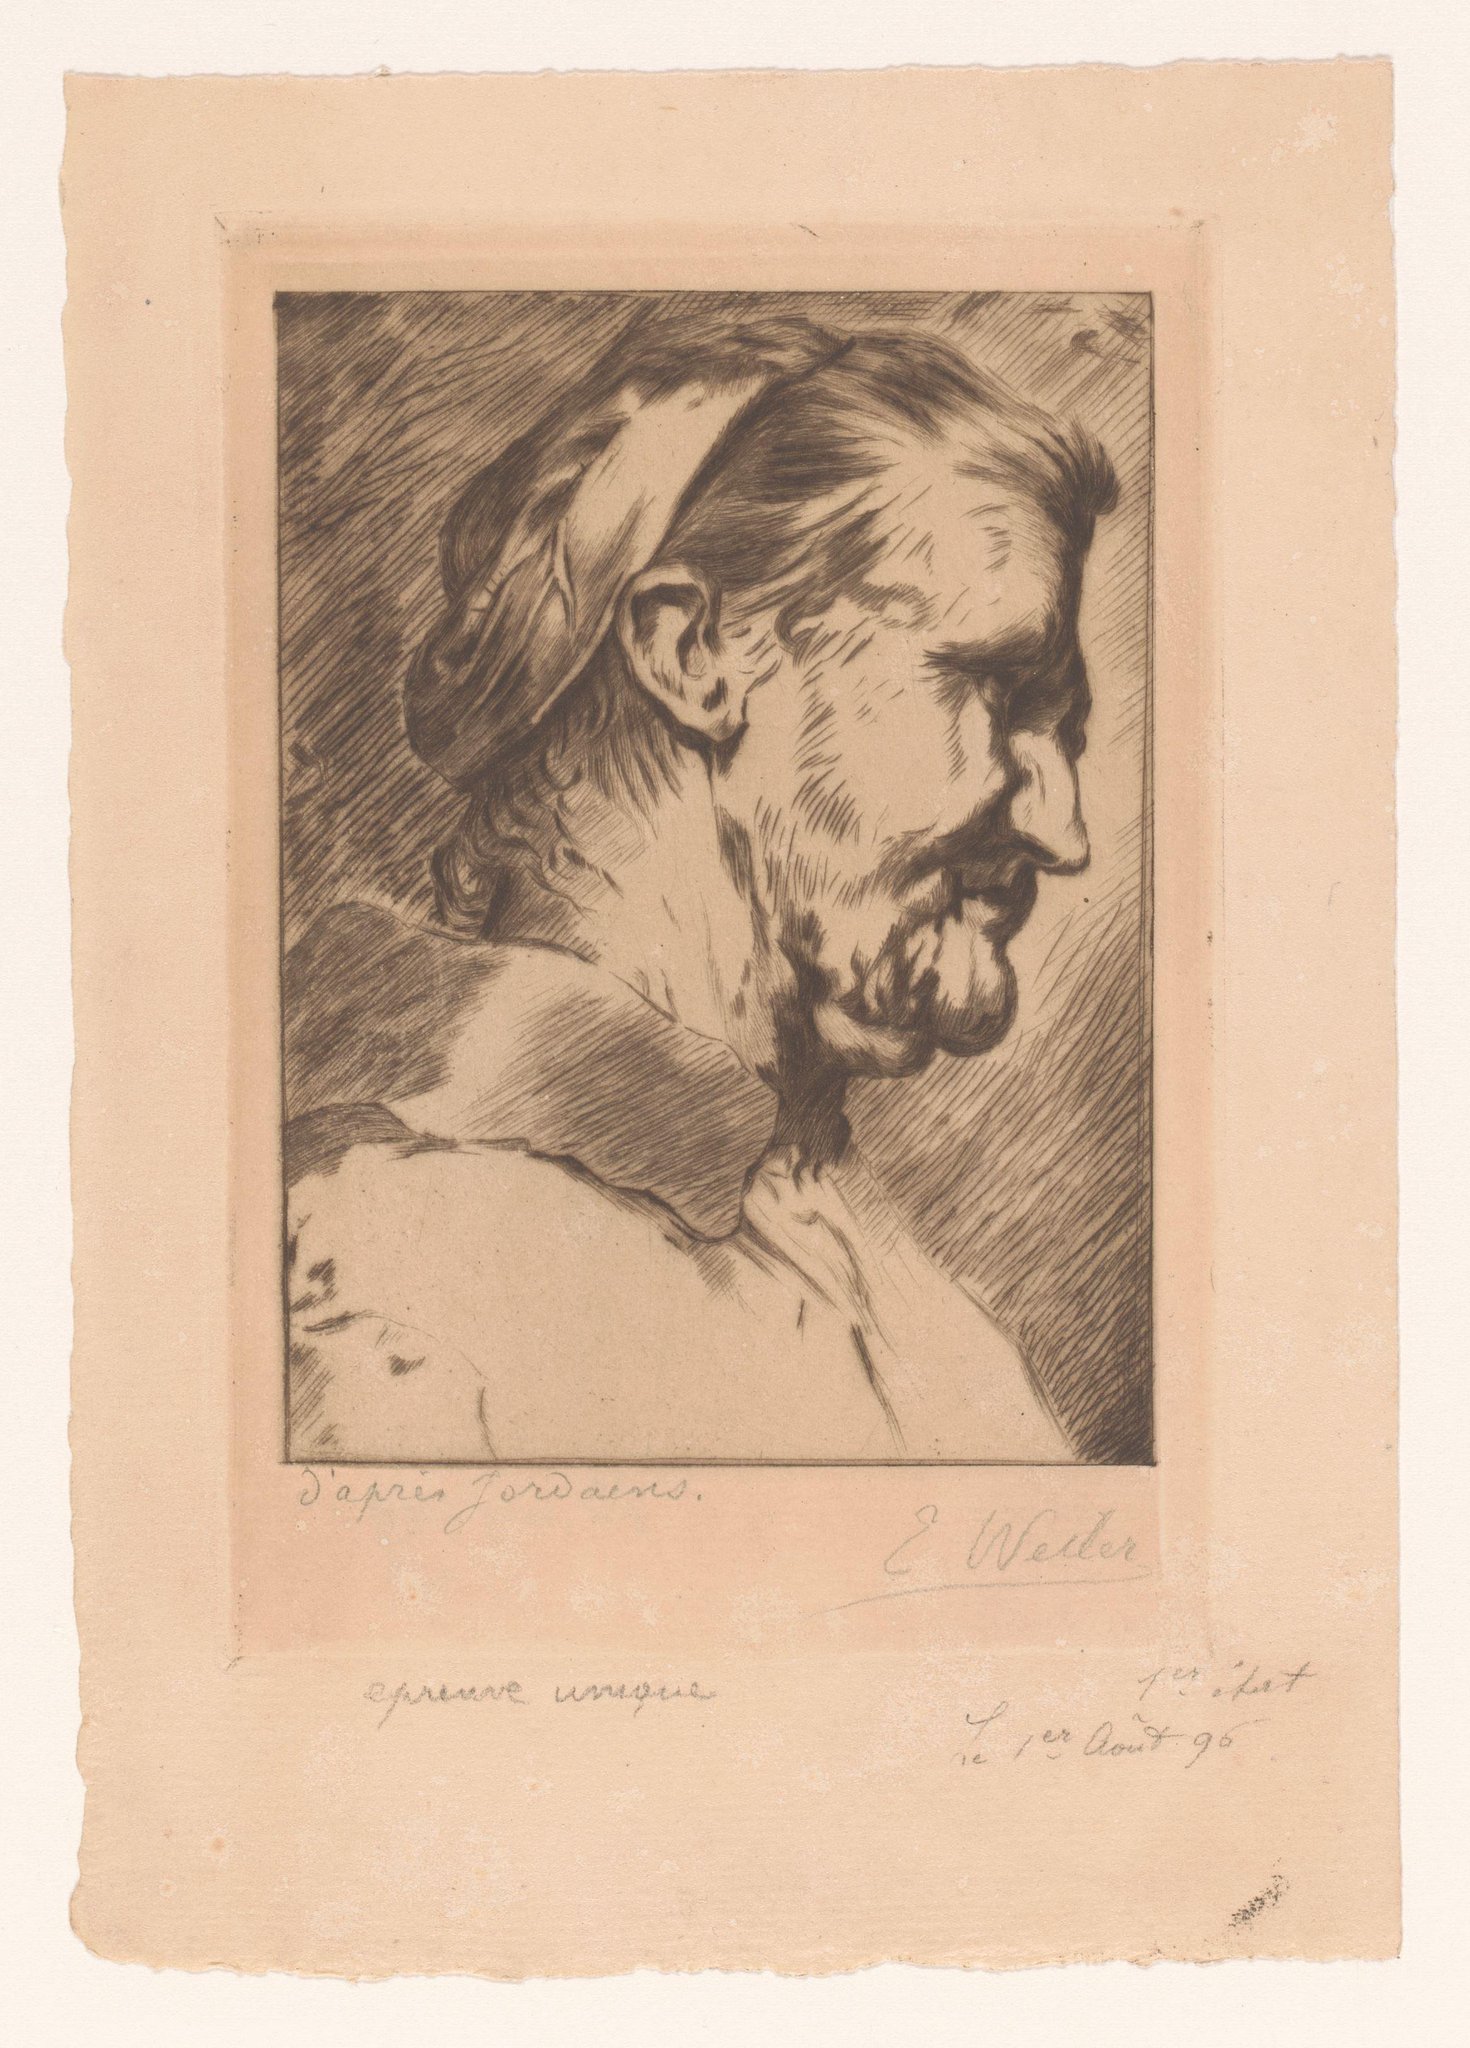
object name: print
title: Hoofd van een oude vrouw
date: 1896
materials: paper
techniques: drypoint, etching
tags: old woman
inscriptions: collector's mark: Lugt 2228, inscription: ‘d'apres Jordaens; epreuve unique; 1er état le 1er Aõut 96’